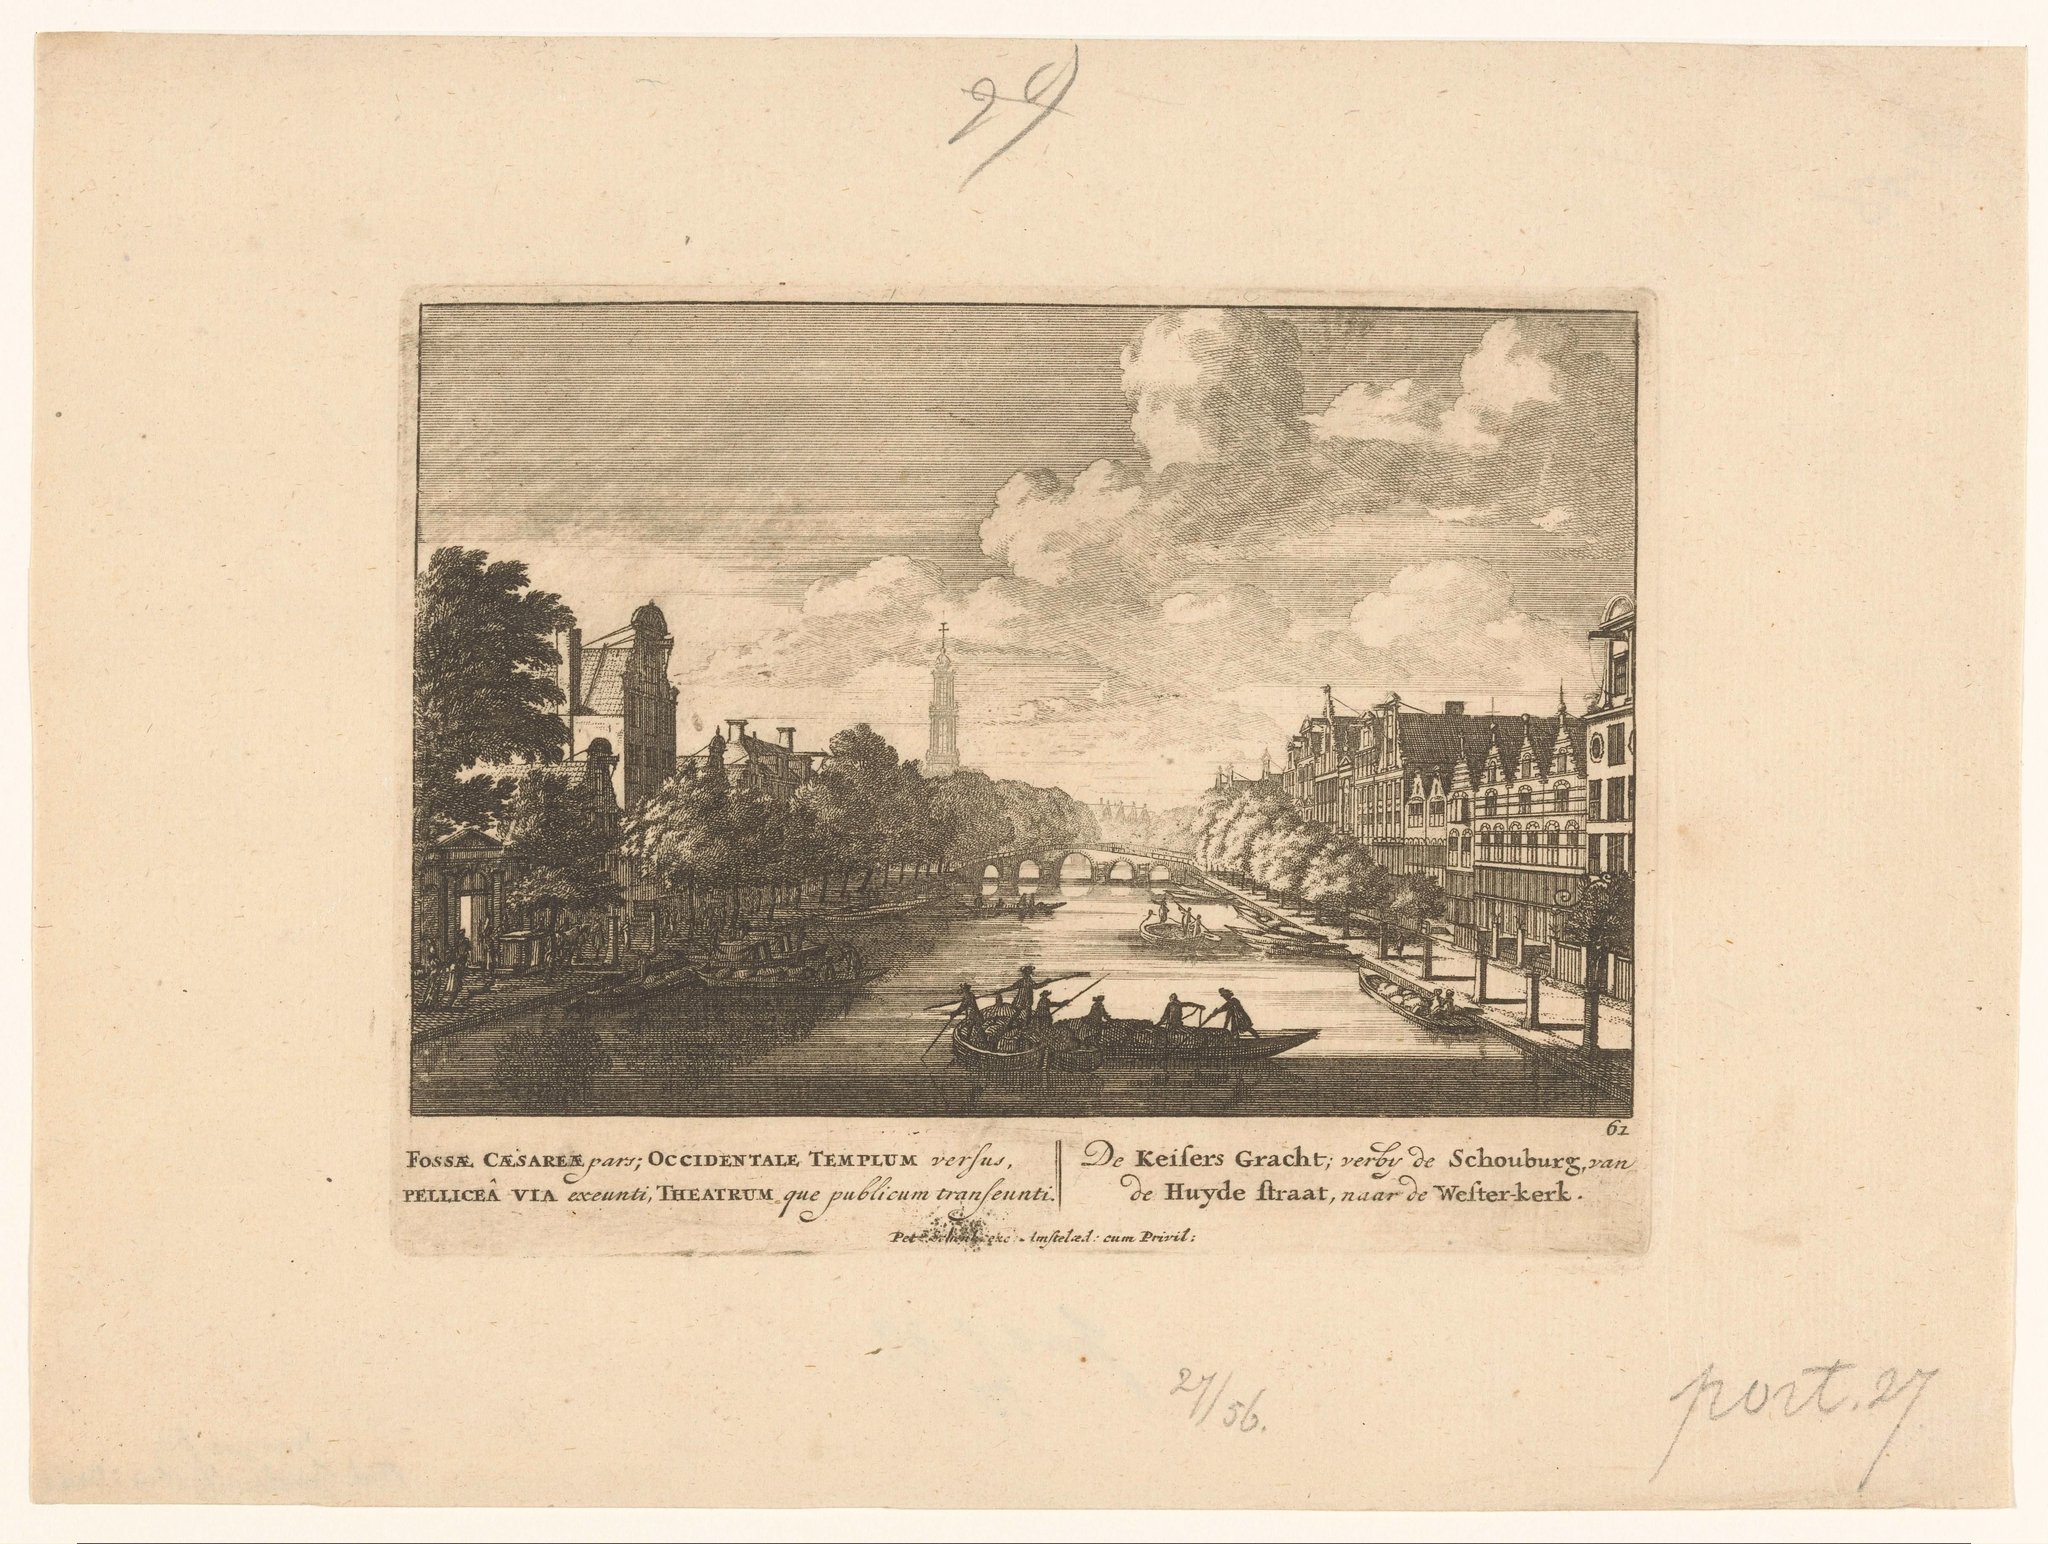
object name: print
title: Admirandorum Quadruplex Spectaculum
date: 1694-1697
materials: paper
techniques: engraving, etching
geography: amsterdam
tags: bridge in city across river, canal, etc., canals, waters (in city) (+ city(-scape) with figures, staffage), street (+ city(-scape) with figures, staffage), parts of church exterior and annexes: tower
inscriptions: collector's mark: Lugt 2228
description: Prent ook gebruikt in: Admirandorum Quadruplex Spectaculum. Amsterdam: Pieter Schenk (I), s.a. [1694-1697].* * De titelprent, opdracht en het portret van Frederik van Saksen zijn gegraveerd door Pieter Schenk (I). De overige prenten uit deze serie zijn, zoals aangegeven op de titelprent, van de hand van Jan van Call (I).